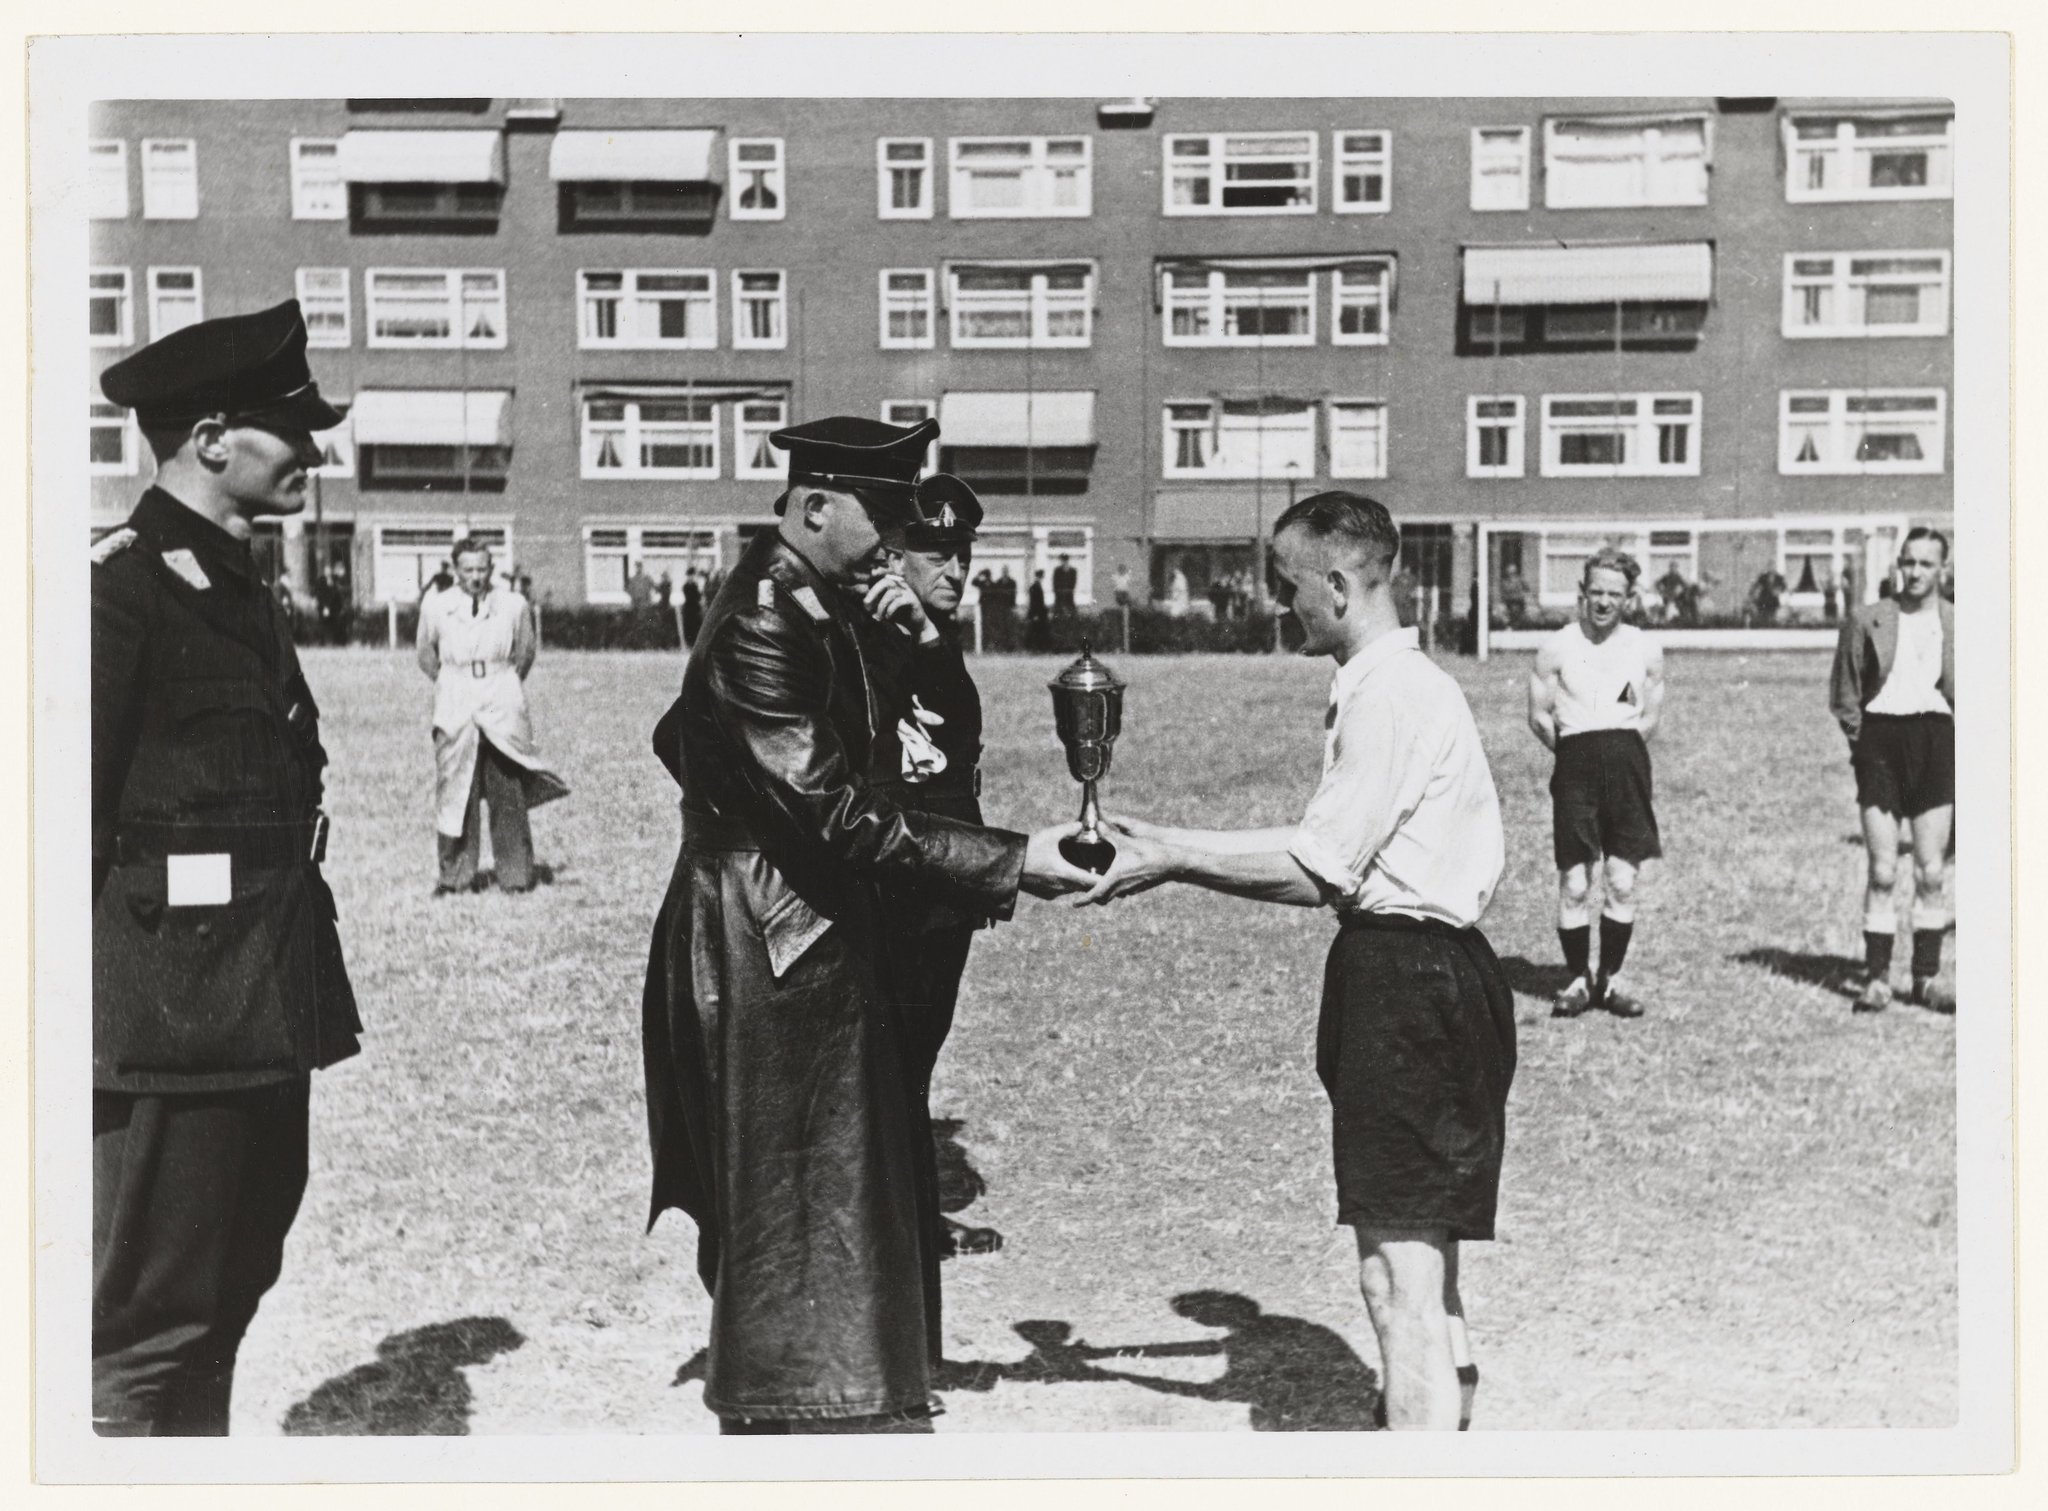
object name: photograph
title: Sportwedstrijd WA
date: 1941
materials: photographic support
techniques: gelatin silver print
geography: amsterdam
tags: soccer, football (early names: soule, choule, cholle), military celebrations, amsterdam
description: Sportwedstrijd van de WA in Amsterdam, misschien het Olympiaplein. Uitreiking van de gewonnen beker aan een van de deelnemers van de winnende ploegen, de boks- en voetbalploeg van Amsterdam, door de WA Heerbanleider Feenstra en waarnemend WA commandant Van 't Hof. Op de achtergrond de huizen aan het Olympiaplein?